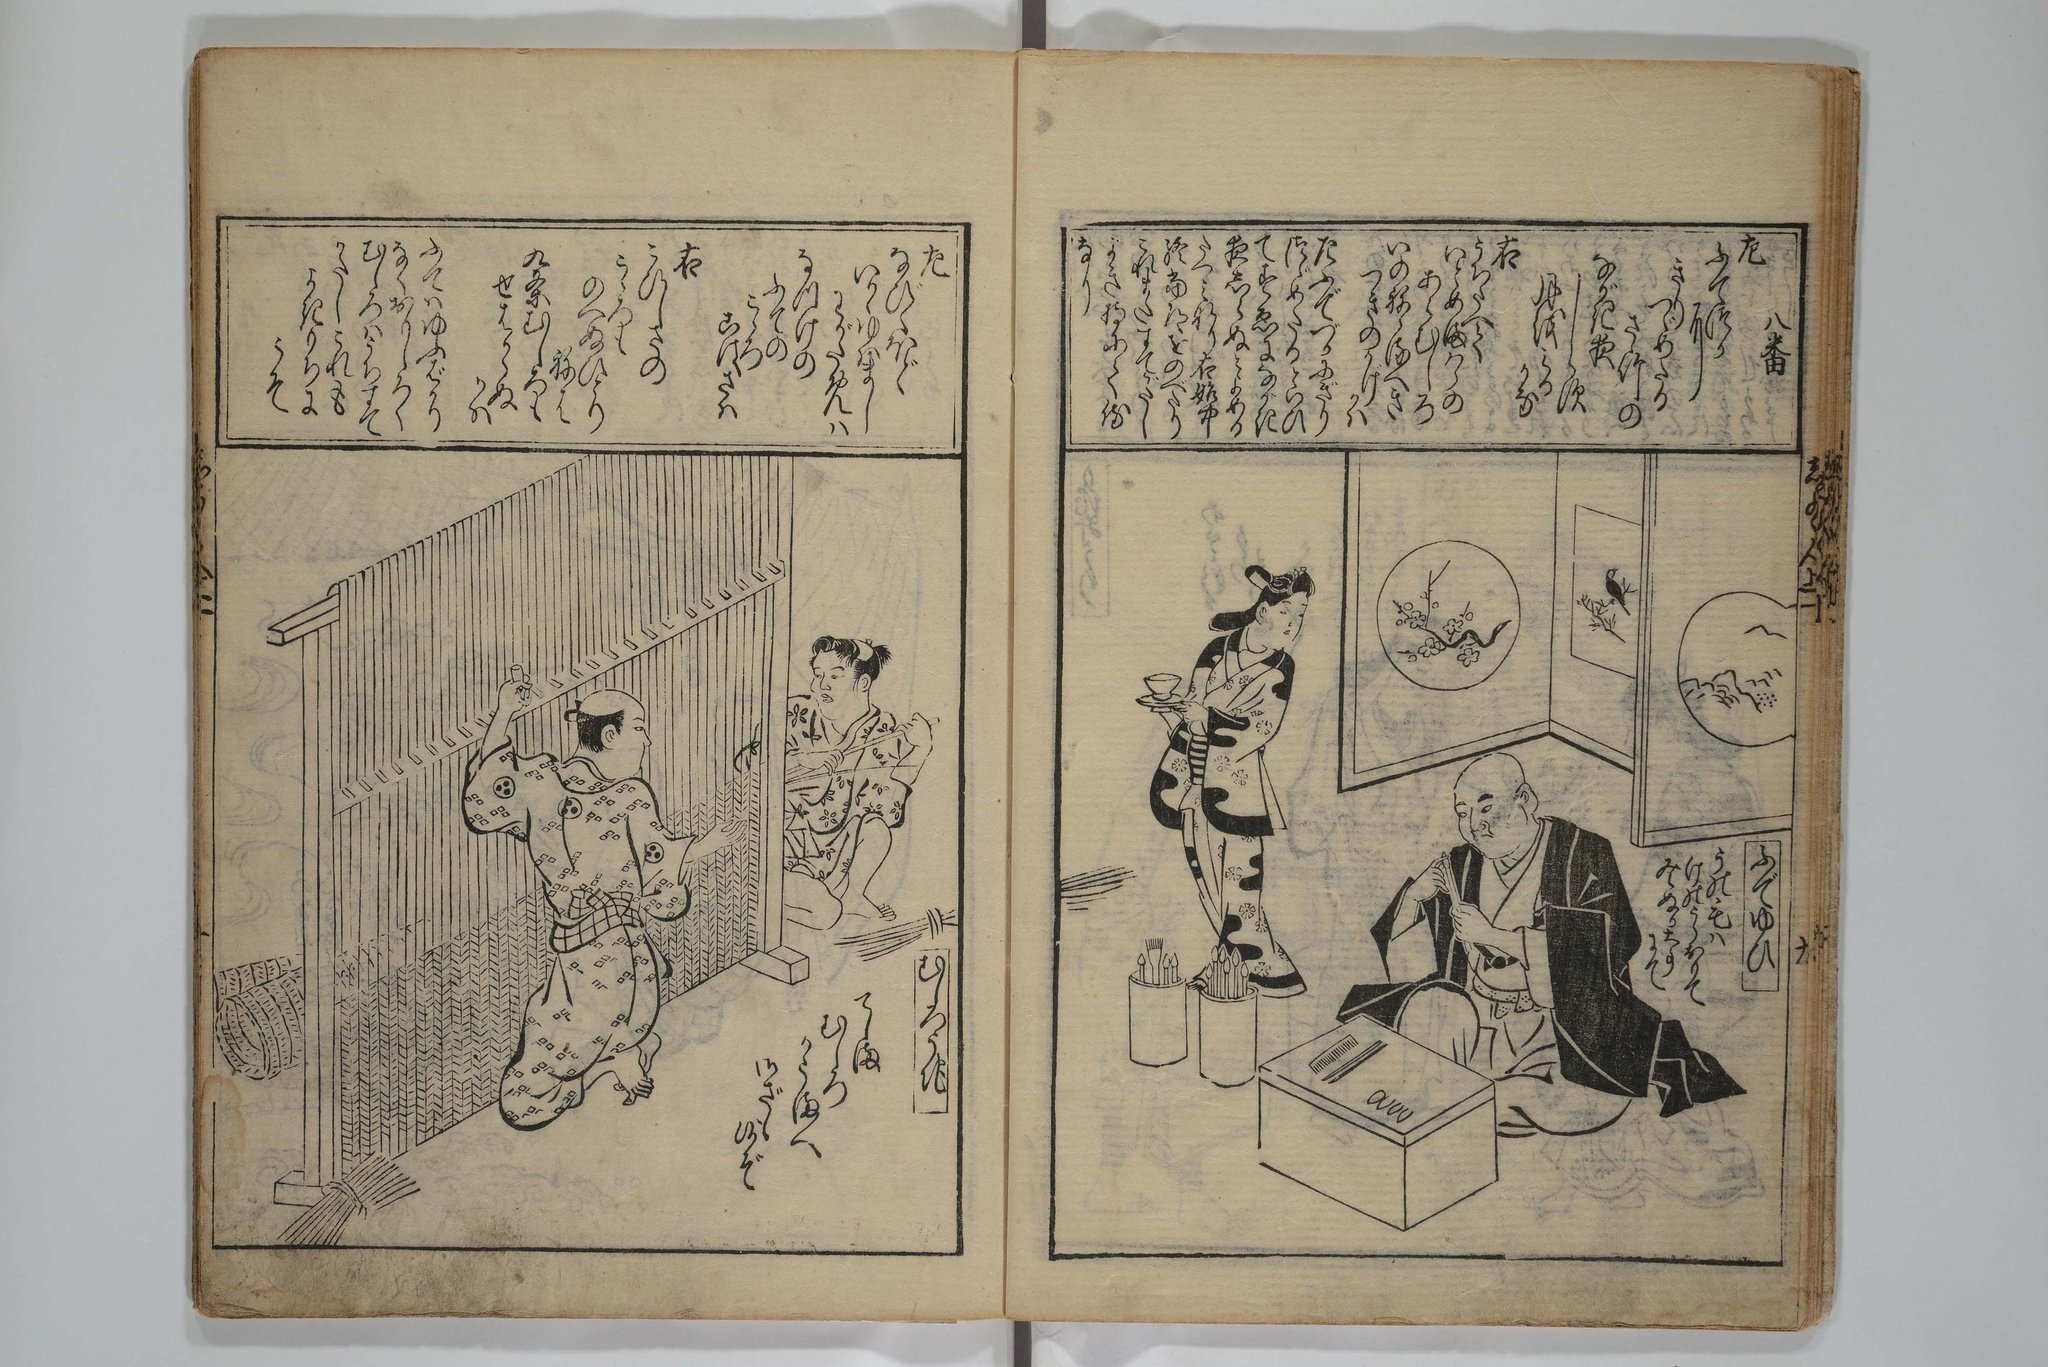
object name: illustrated book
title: A Picture Book Mirror of Various Occupations (Wakoku shoshoku ezukushi) 和国諸職絵尽 諸織 絵本鏡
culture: japanese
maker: hishikawa moronobu 菱川師宣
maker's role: artist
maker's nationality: japanese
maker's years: 1618-1694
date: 1685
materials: ink, paper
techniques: woodblock print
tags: men,women,working